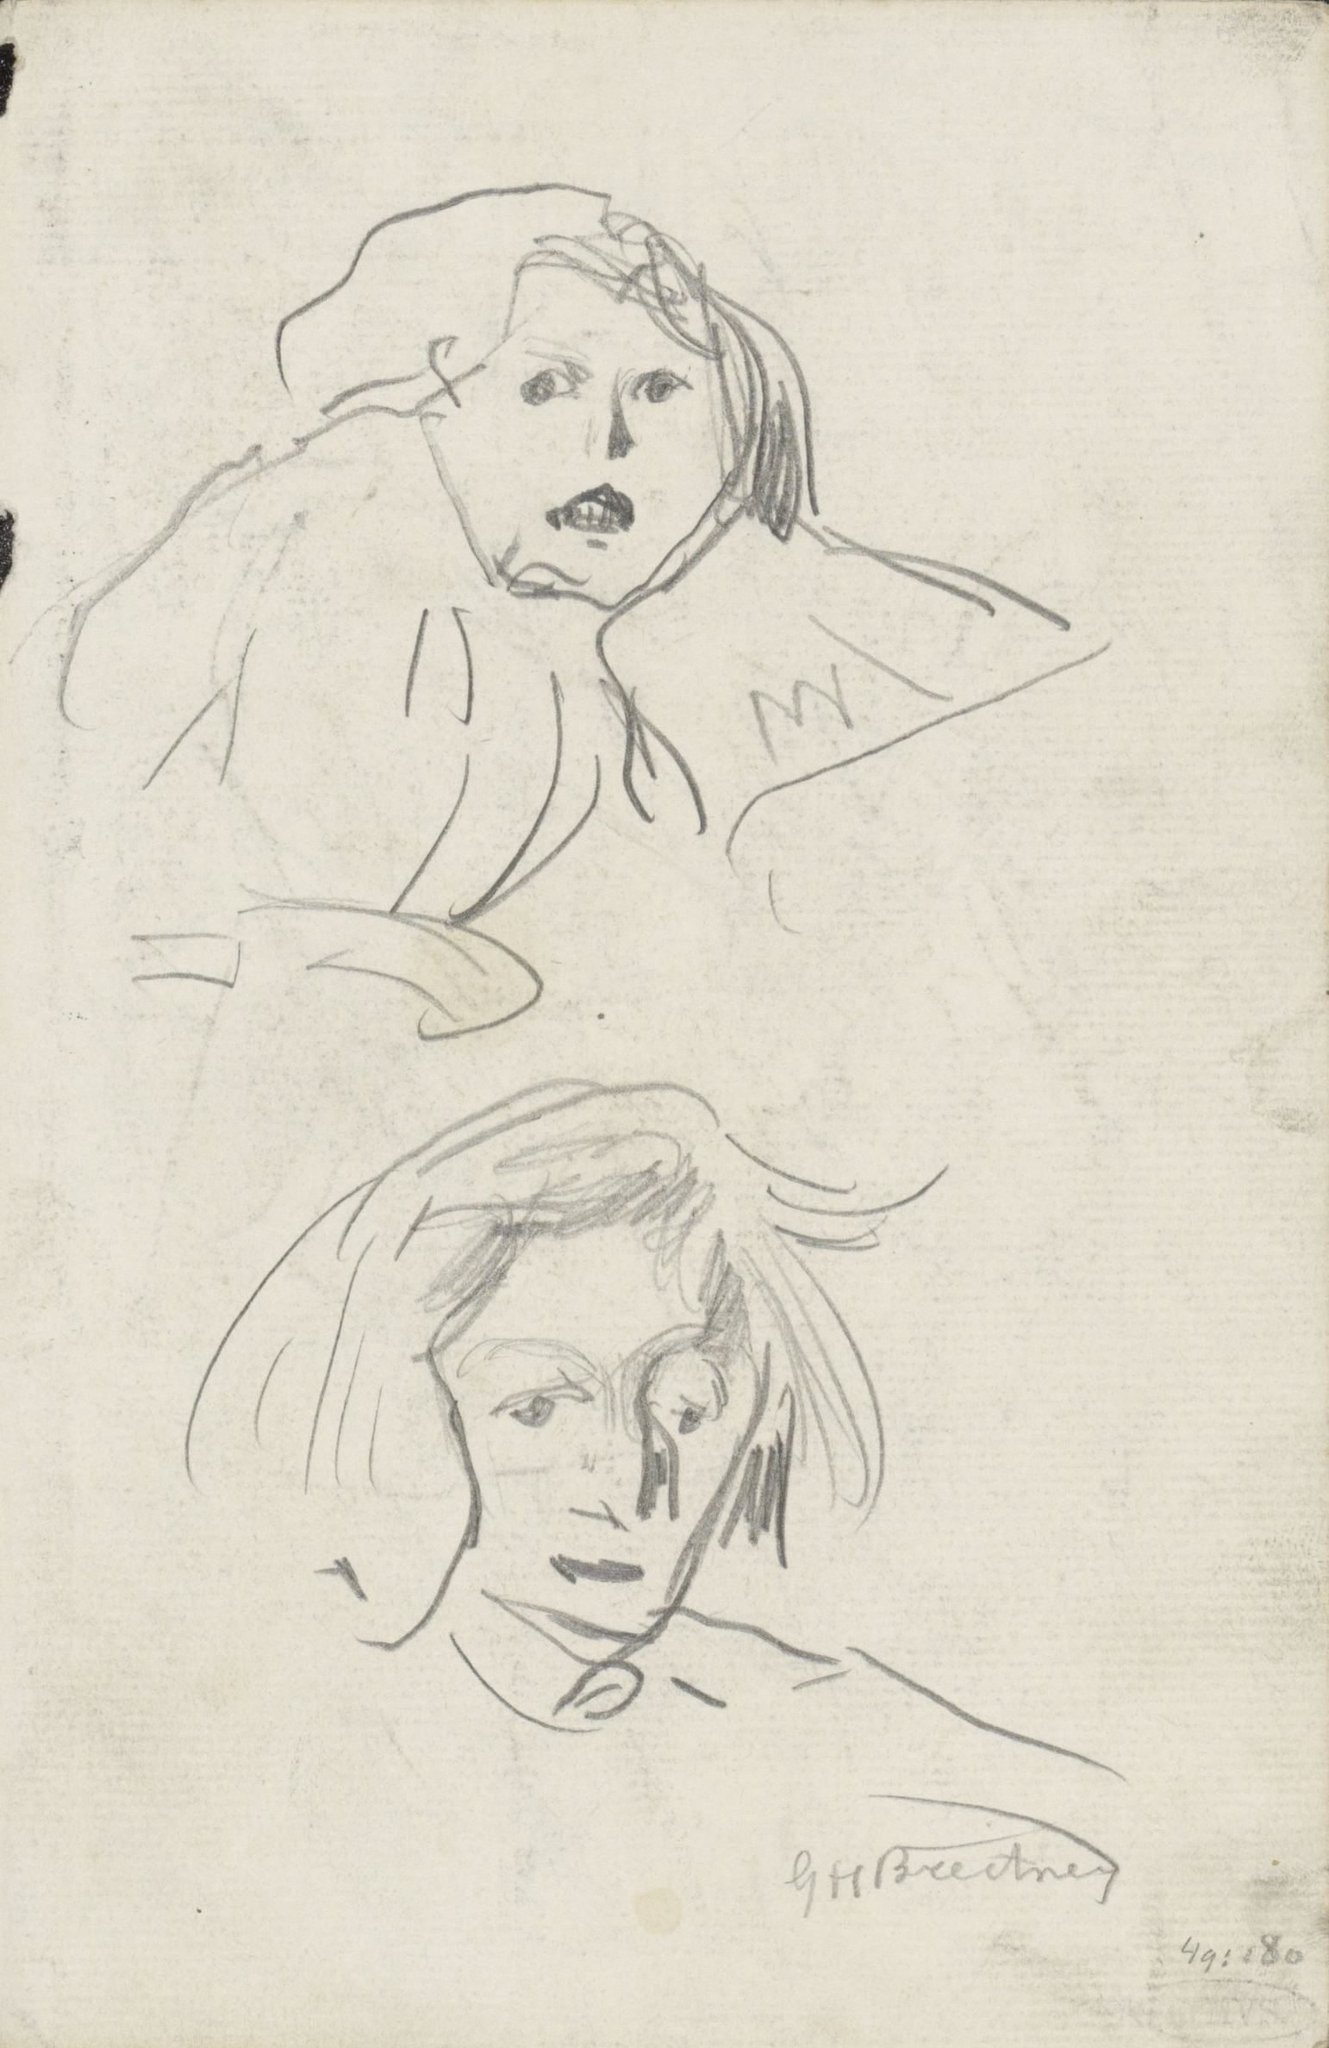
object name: drawing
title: Twee vrouwenbustes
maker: george hendrik breitner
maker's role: draughtsman, painter, print maker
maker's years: 1857-1923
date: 1912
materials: paper, pencil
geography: amsterdam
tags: adult woman, head (human) - aa - female human figure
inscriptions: signature: ‘G H Breitner’